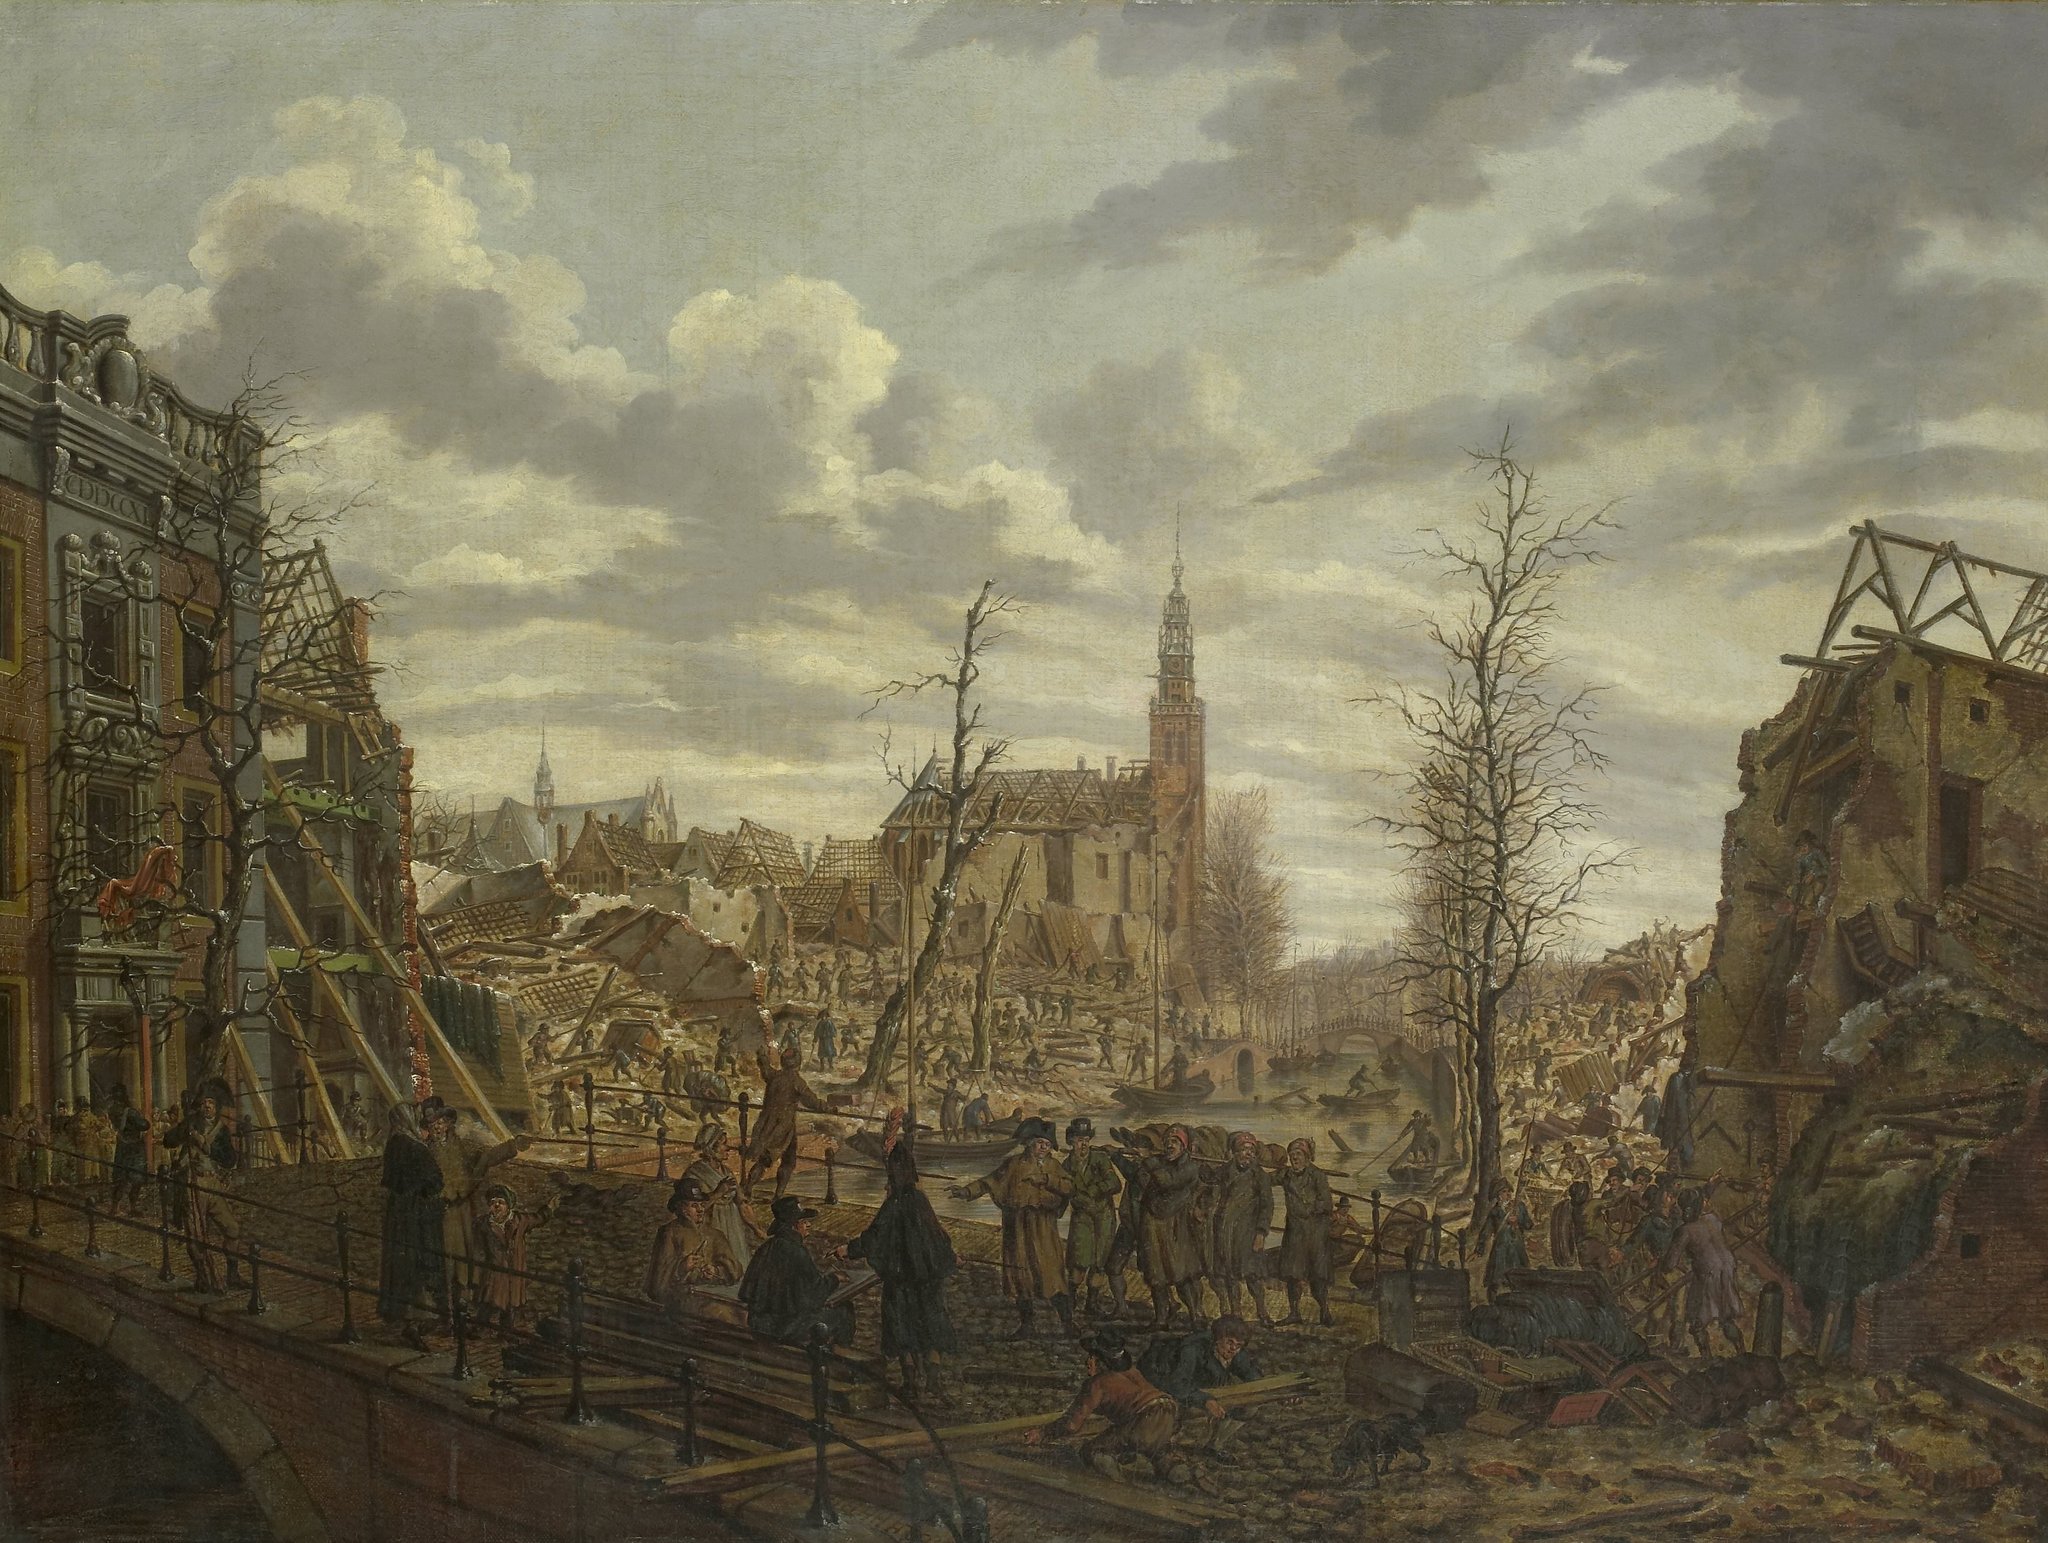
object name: painting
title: The Rapenburg, Leiden, three Days after the Explosion of a Powder Ship on 12 January 1807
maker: johannes jelgerhuis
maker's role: draughtsman, painter, print maker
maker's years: 1770-1836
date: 1807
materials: canvas, oil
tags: landscape with ruins, public road, gunpowder disaster, leiden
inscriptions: signature, date and inscription: ‘I. Jelgerhuis Rz. Acteur aan den Schouwburg te Amsterdam fecit. Het Raepenburg te Leyden. 15 Januari 1807.’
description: Gezicht op het Rapenburg te Leiden, drie dagen na de ontploffing van het kruitschip op 12 januari 1807. Op de brug op de voorgrond staan toeschouwers en soldaten, enkele mannen dragen een slachtoffer op een draagbaar weg. Rechts opgestapelde huisraad. De locatie van de ramp was het Steenschuur, een gracht in het verlengde van het Rapenburg.